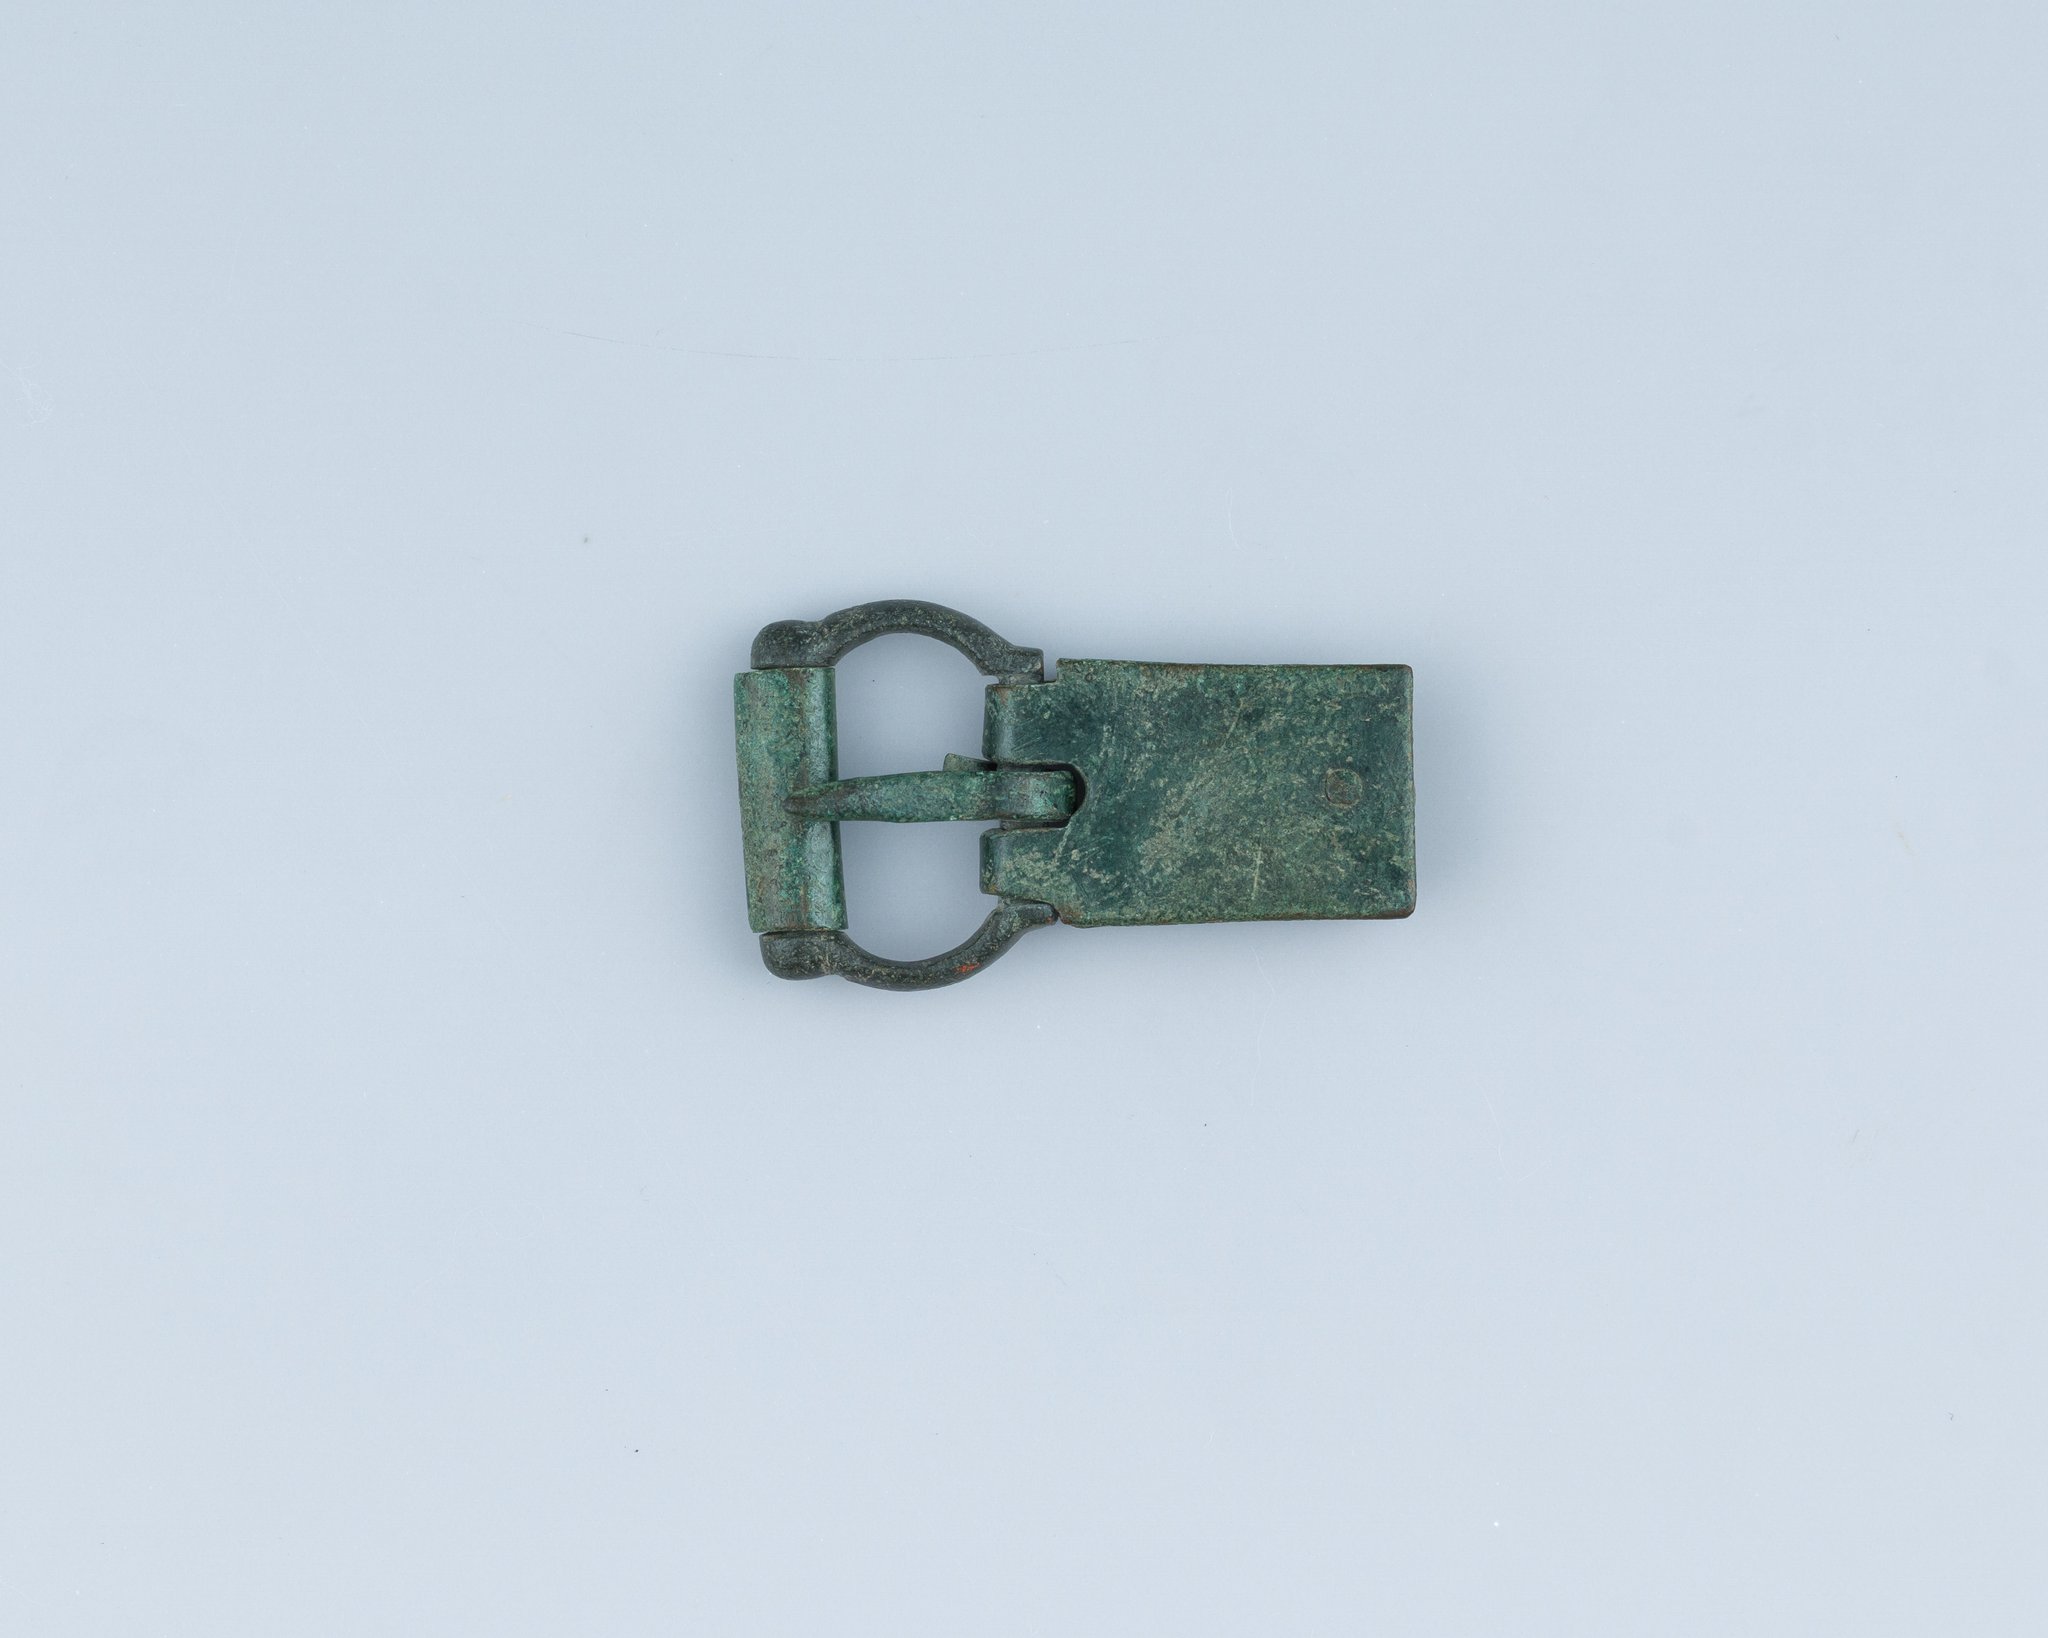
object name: buckle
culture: european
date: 1401-1600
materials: bronze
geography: germany